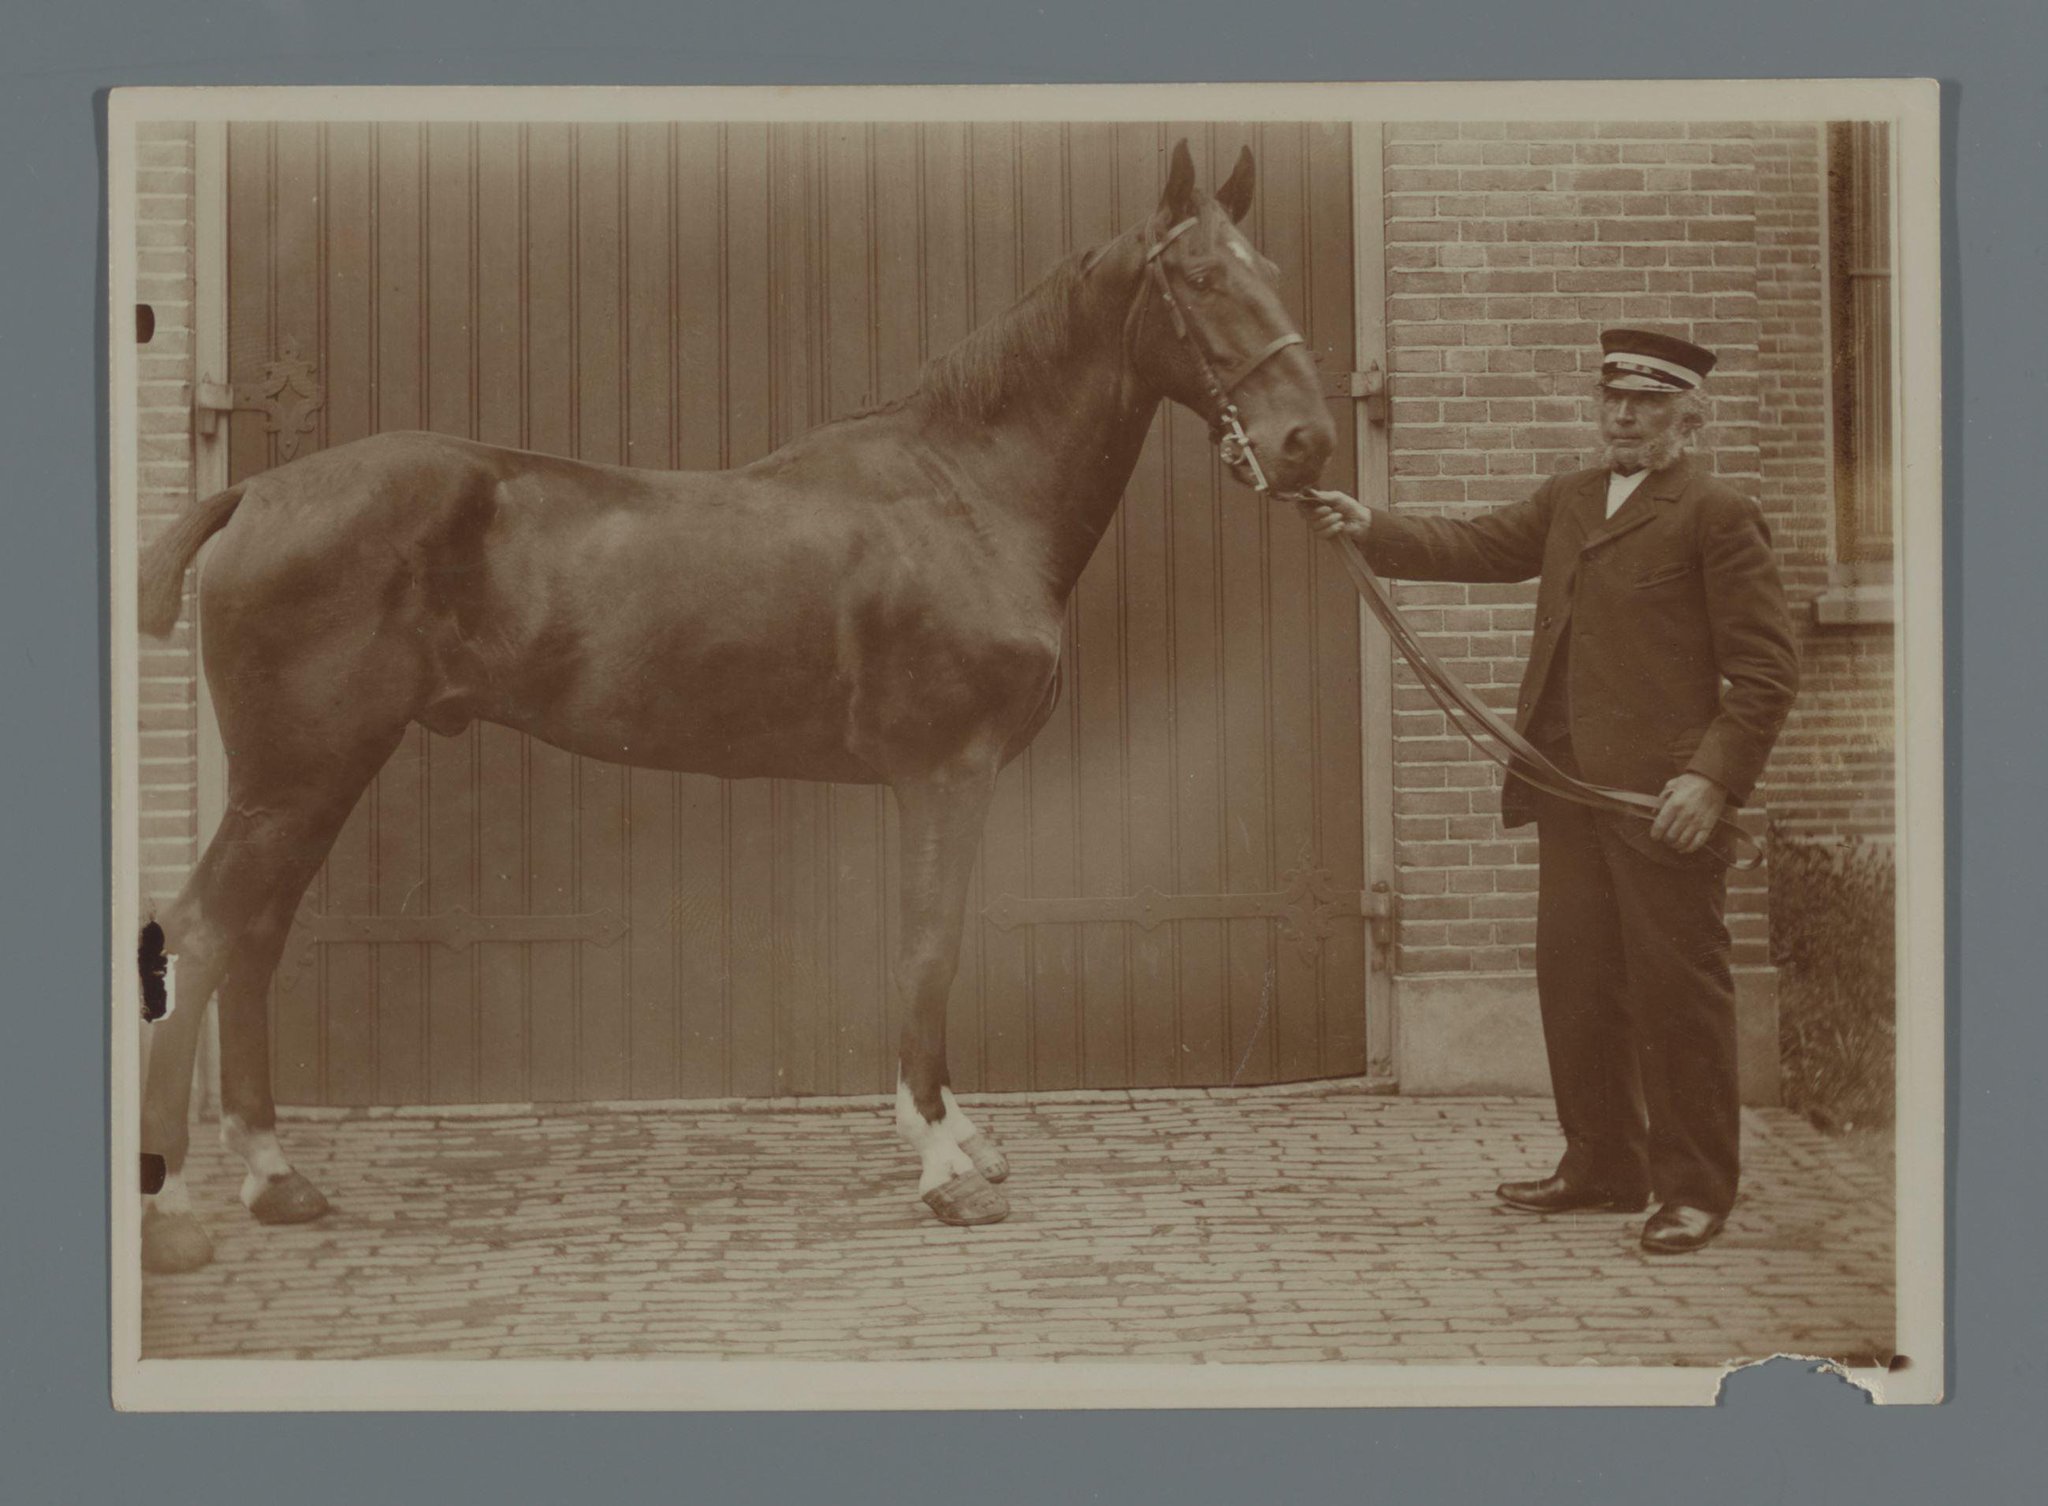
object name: photograph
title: Het paard Bobbie met man aan teugel voor de schuur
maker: hendrik herman van den berg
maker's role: amateurfotograaf, jurist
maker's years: 1875-1944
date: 1896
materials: cardboard, photographic support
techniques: collodion silver print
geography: baarn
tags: leading a horse by the reins; rider beside his horse